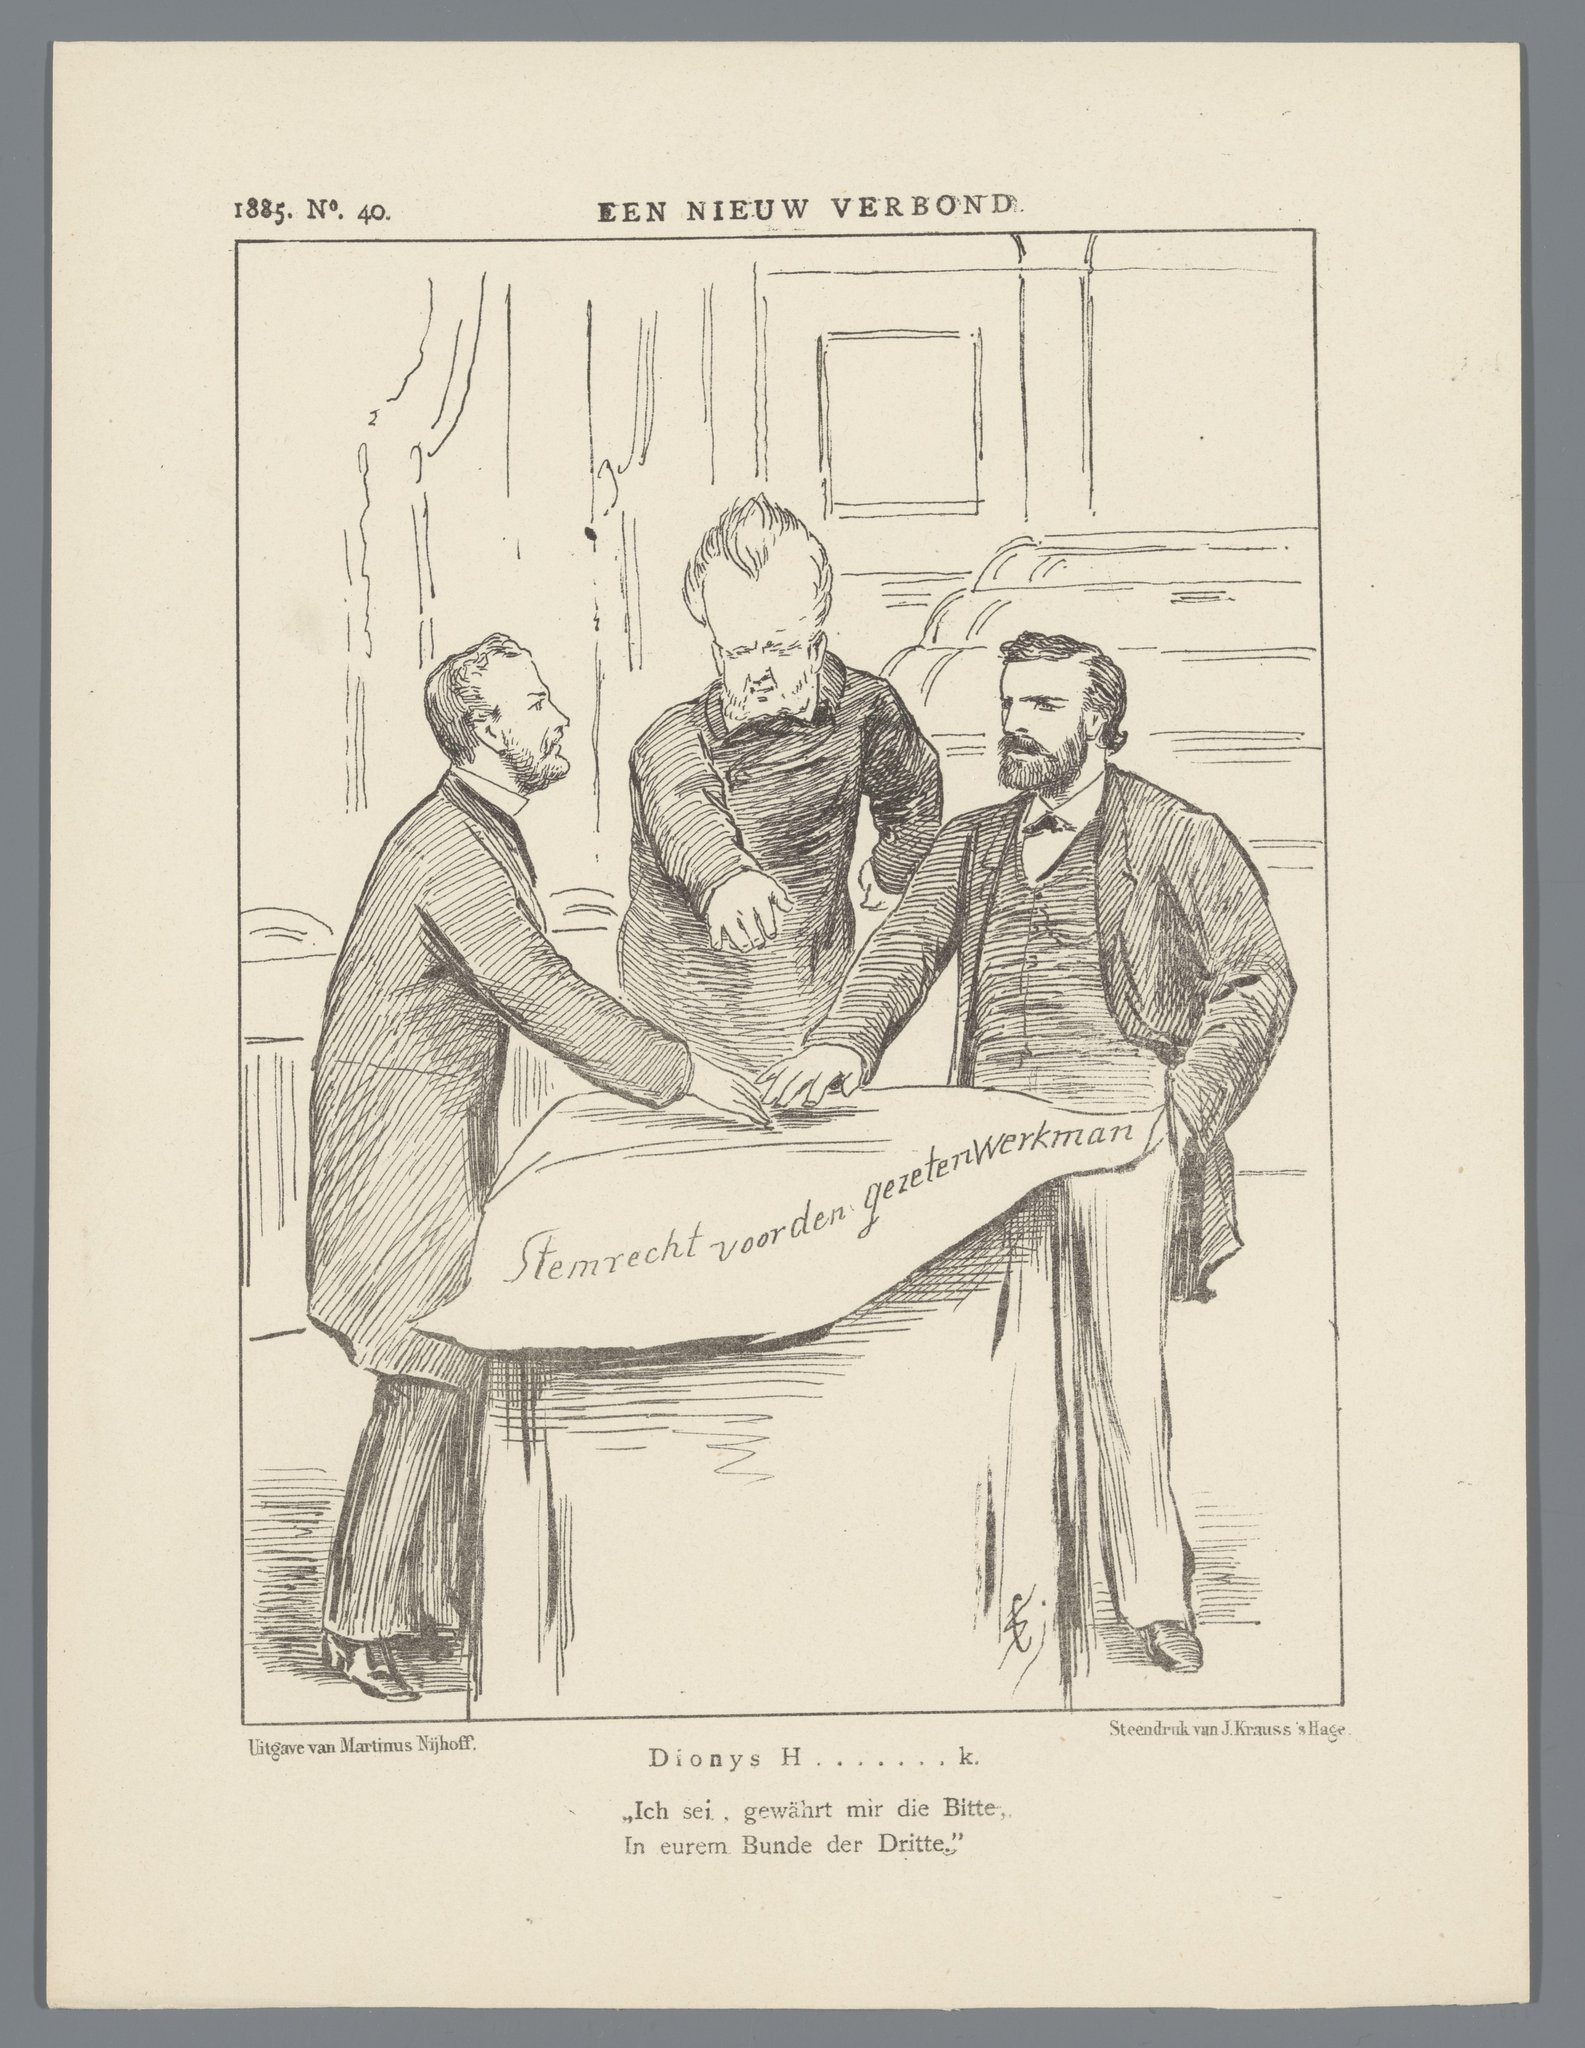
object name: cartoon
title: Spotprent over stemrecht, 1885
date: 1885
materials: paper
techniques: lithograph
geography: the hague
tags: amsterdam, the hague, politician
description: Spotprent over stemrecht voor de gezeten werkman. Plaat verschenen bij het weekblad De Nederlandsche Spectator, nr. 40, 1885.